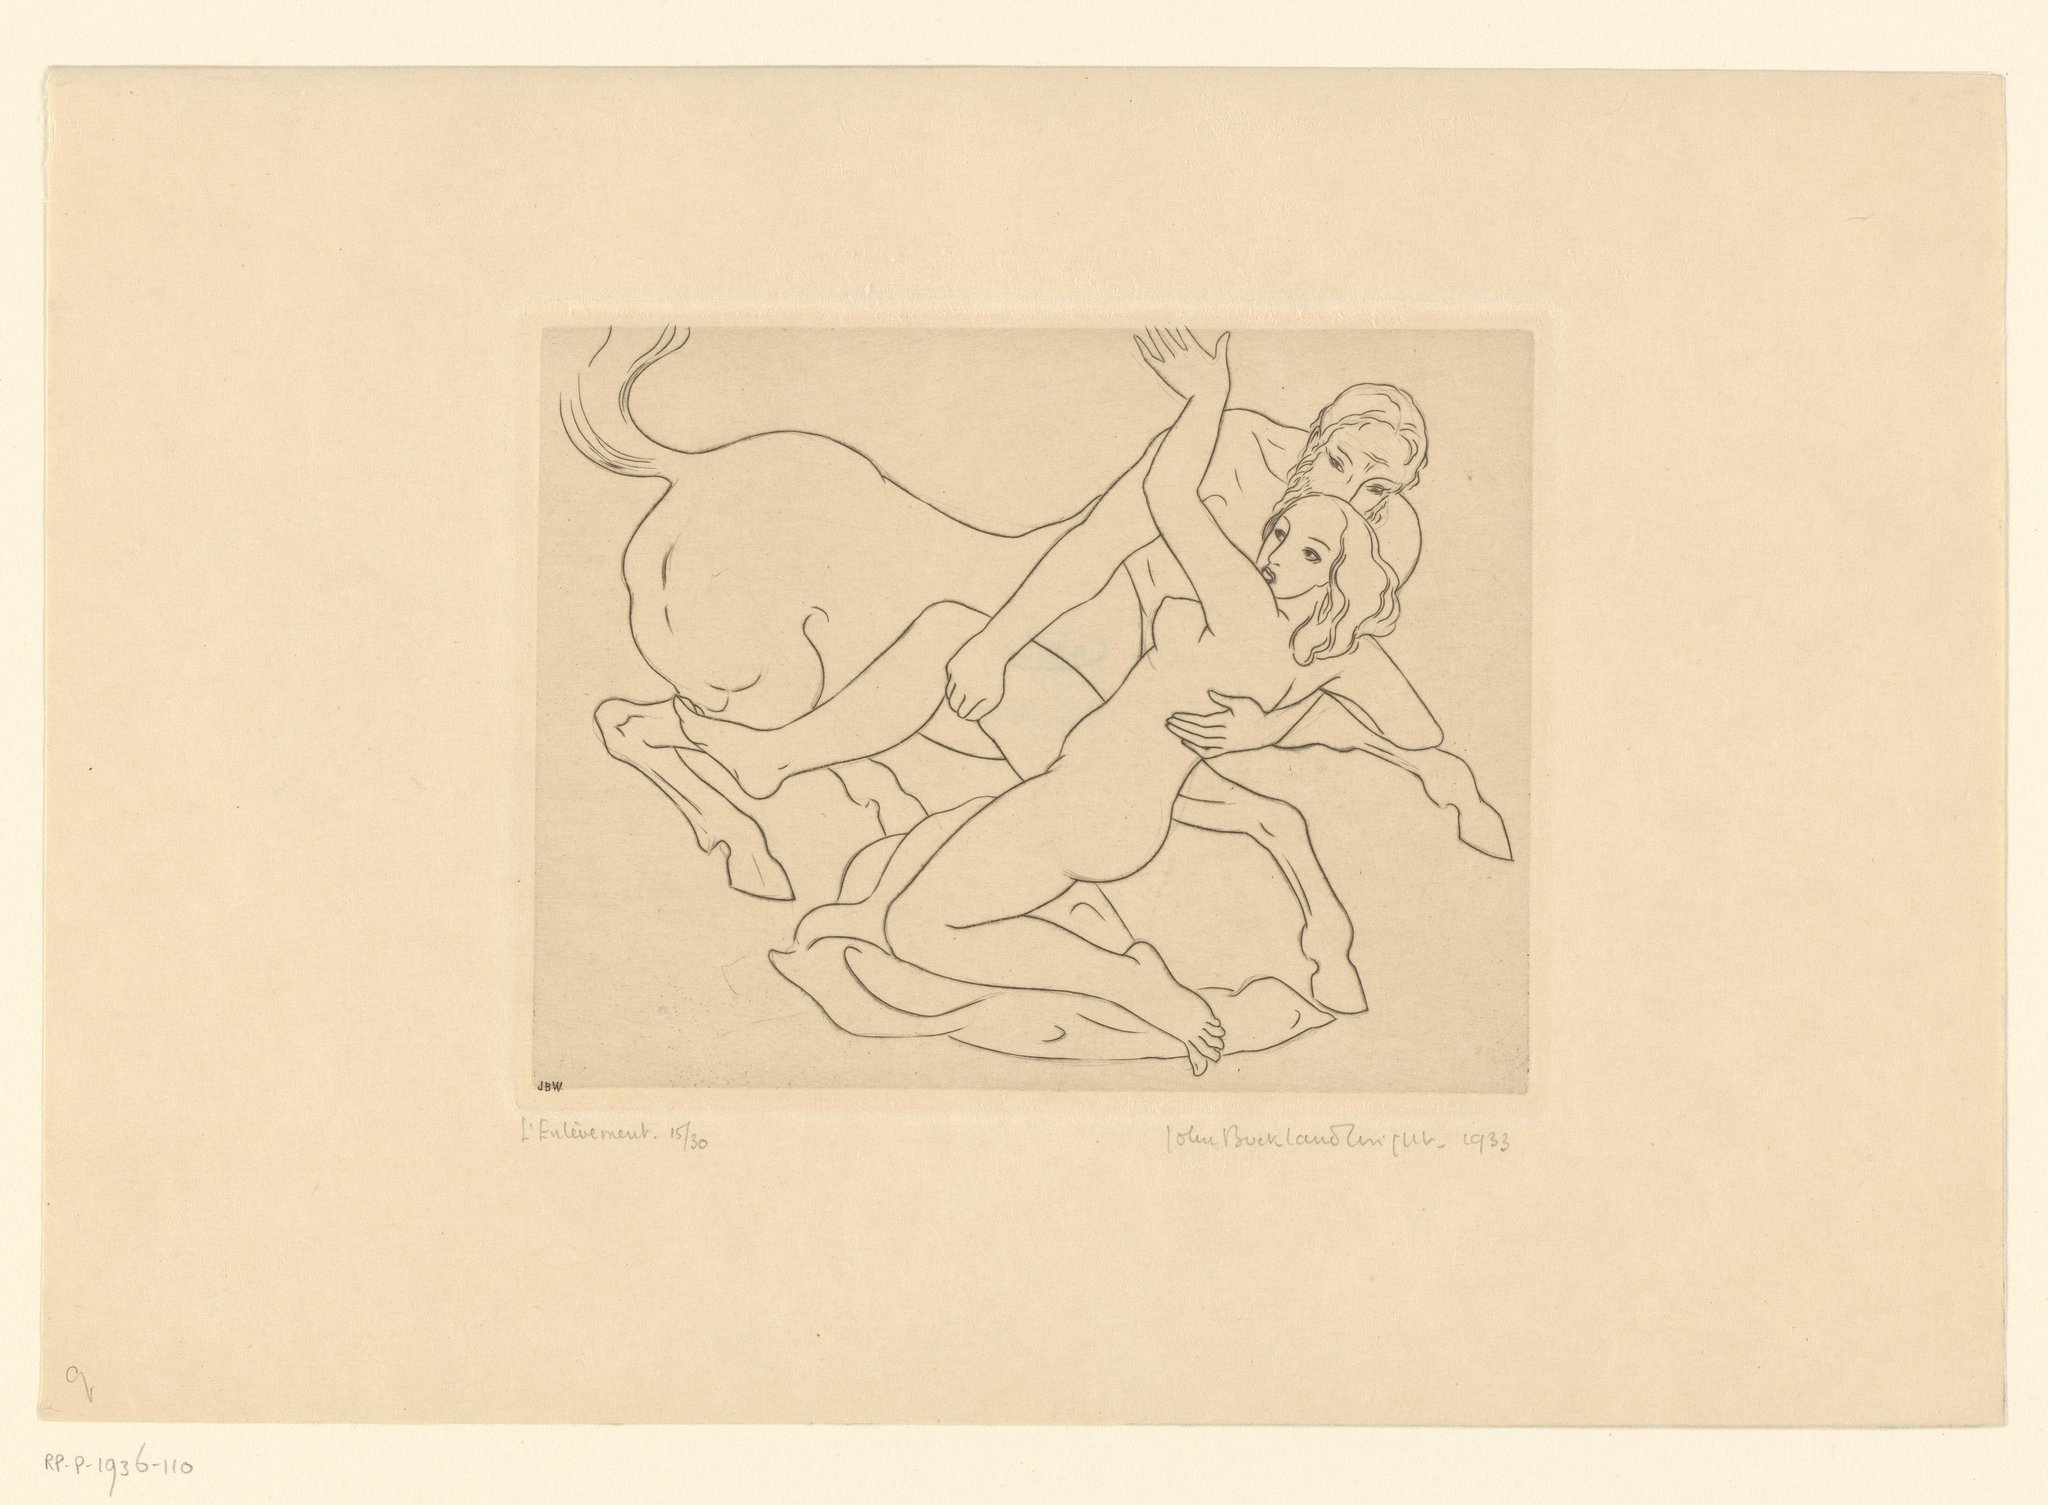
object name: print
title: L'Enlèvement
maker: john buckland wright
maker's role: print maker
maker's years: 1897-1954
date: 1933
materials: paper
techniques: engraving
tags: the centaur eurytion tries to carry off hippodamia, the bride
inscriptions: collector's mark: Lugt 2228